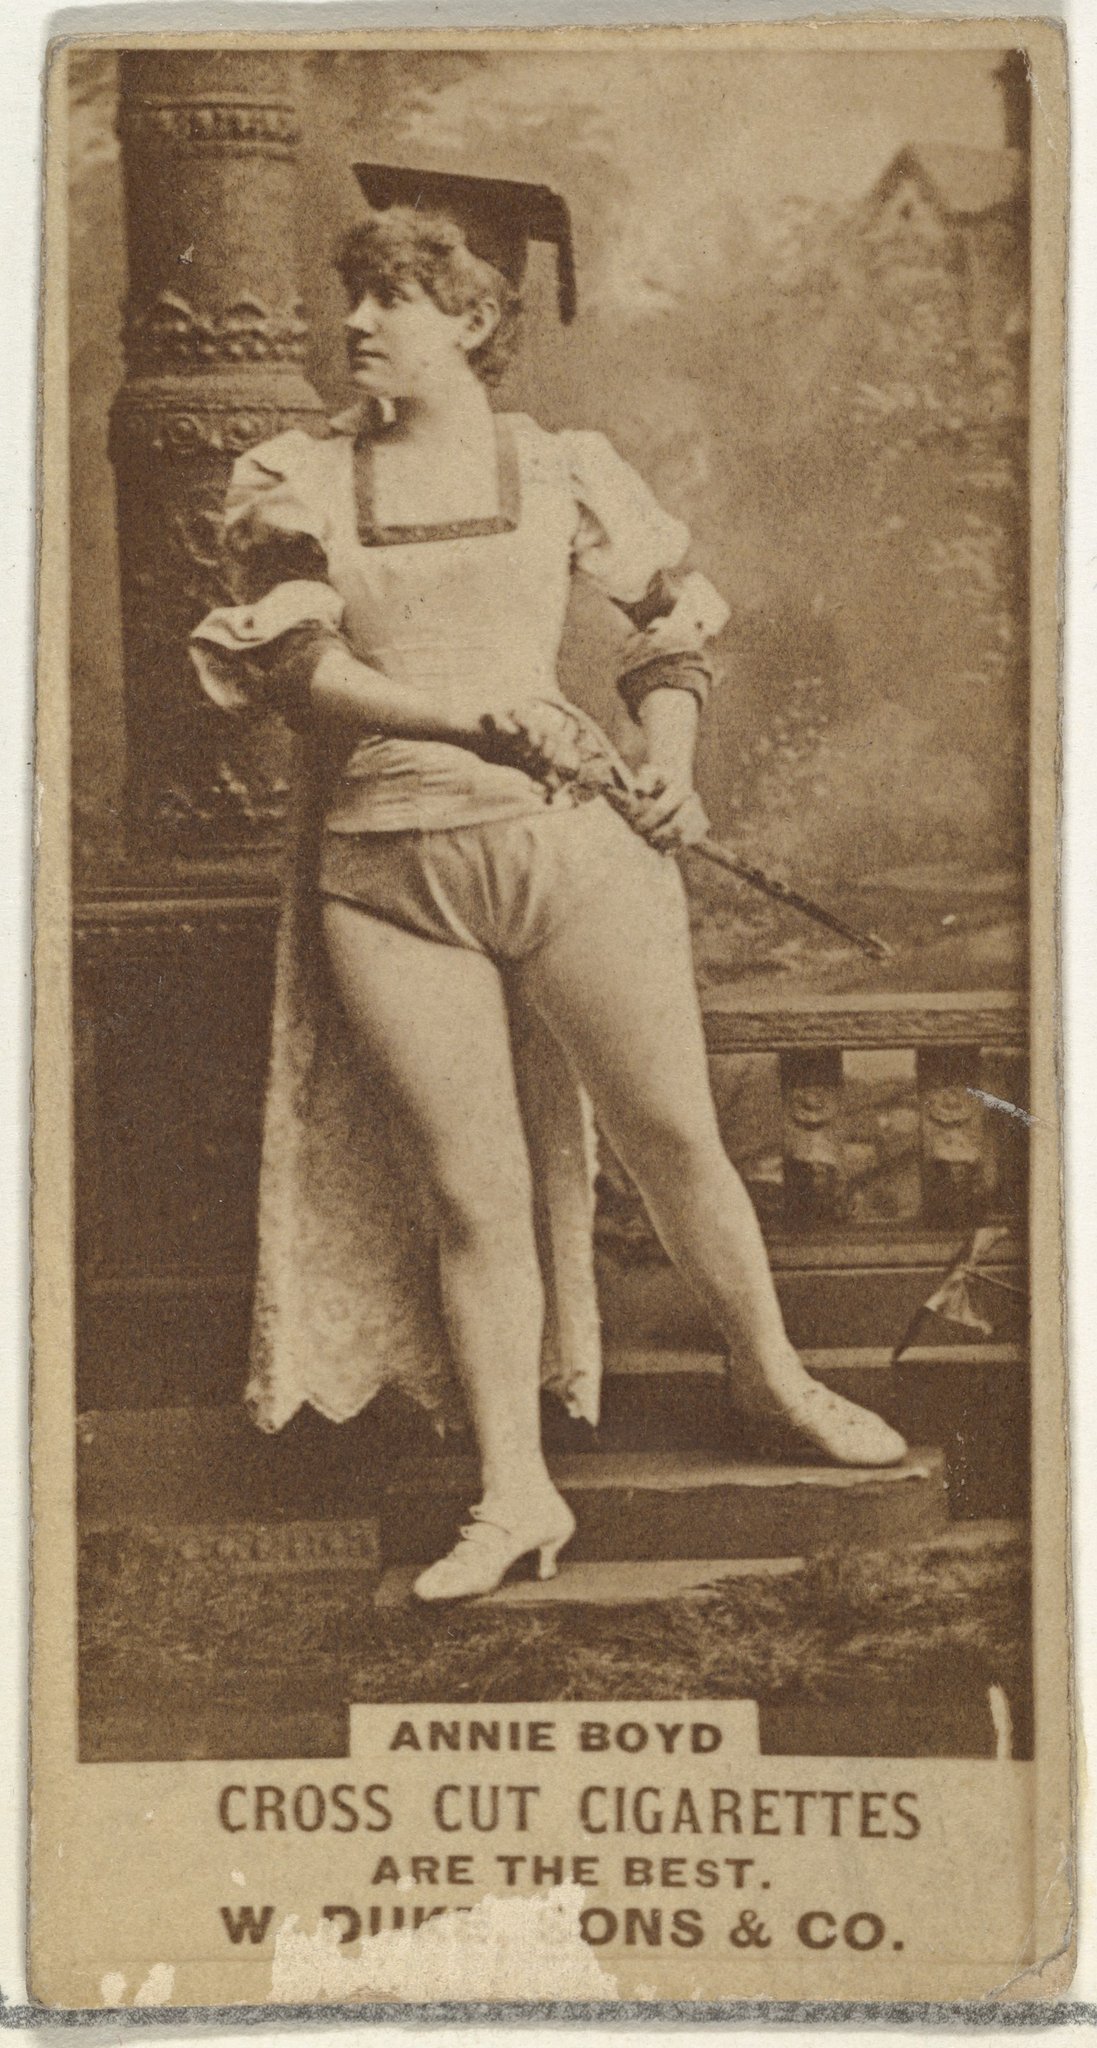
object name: photograph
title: Annie Boyd, from the Actors and Actresses series (N145-3) issued by Duke Sons & Co. to promote Cross Cut Cigarettes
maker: w. duke, sons & co.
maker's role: publisher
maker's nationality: american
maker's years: 1870-1920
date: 1880-1889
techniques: albumen silver print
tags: portraits,women,actresses